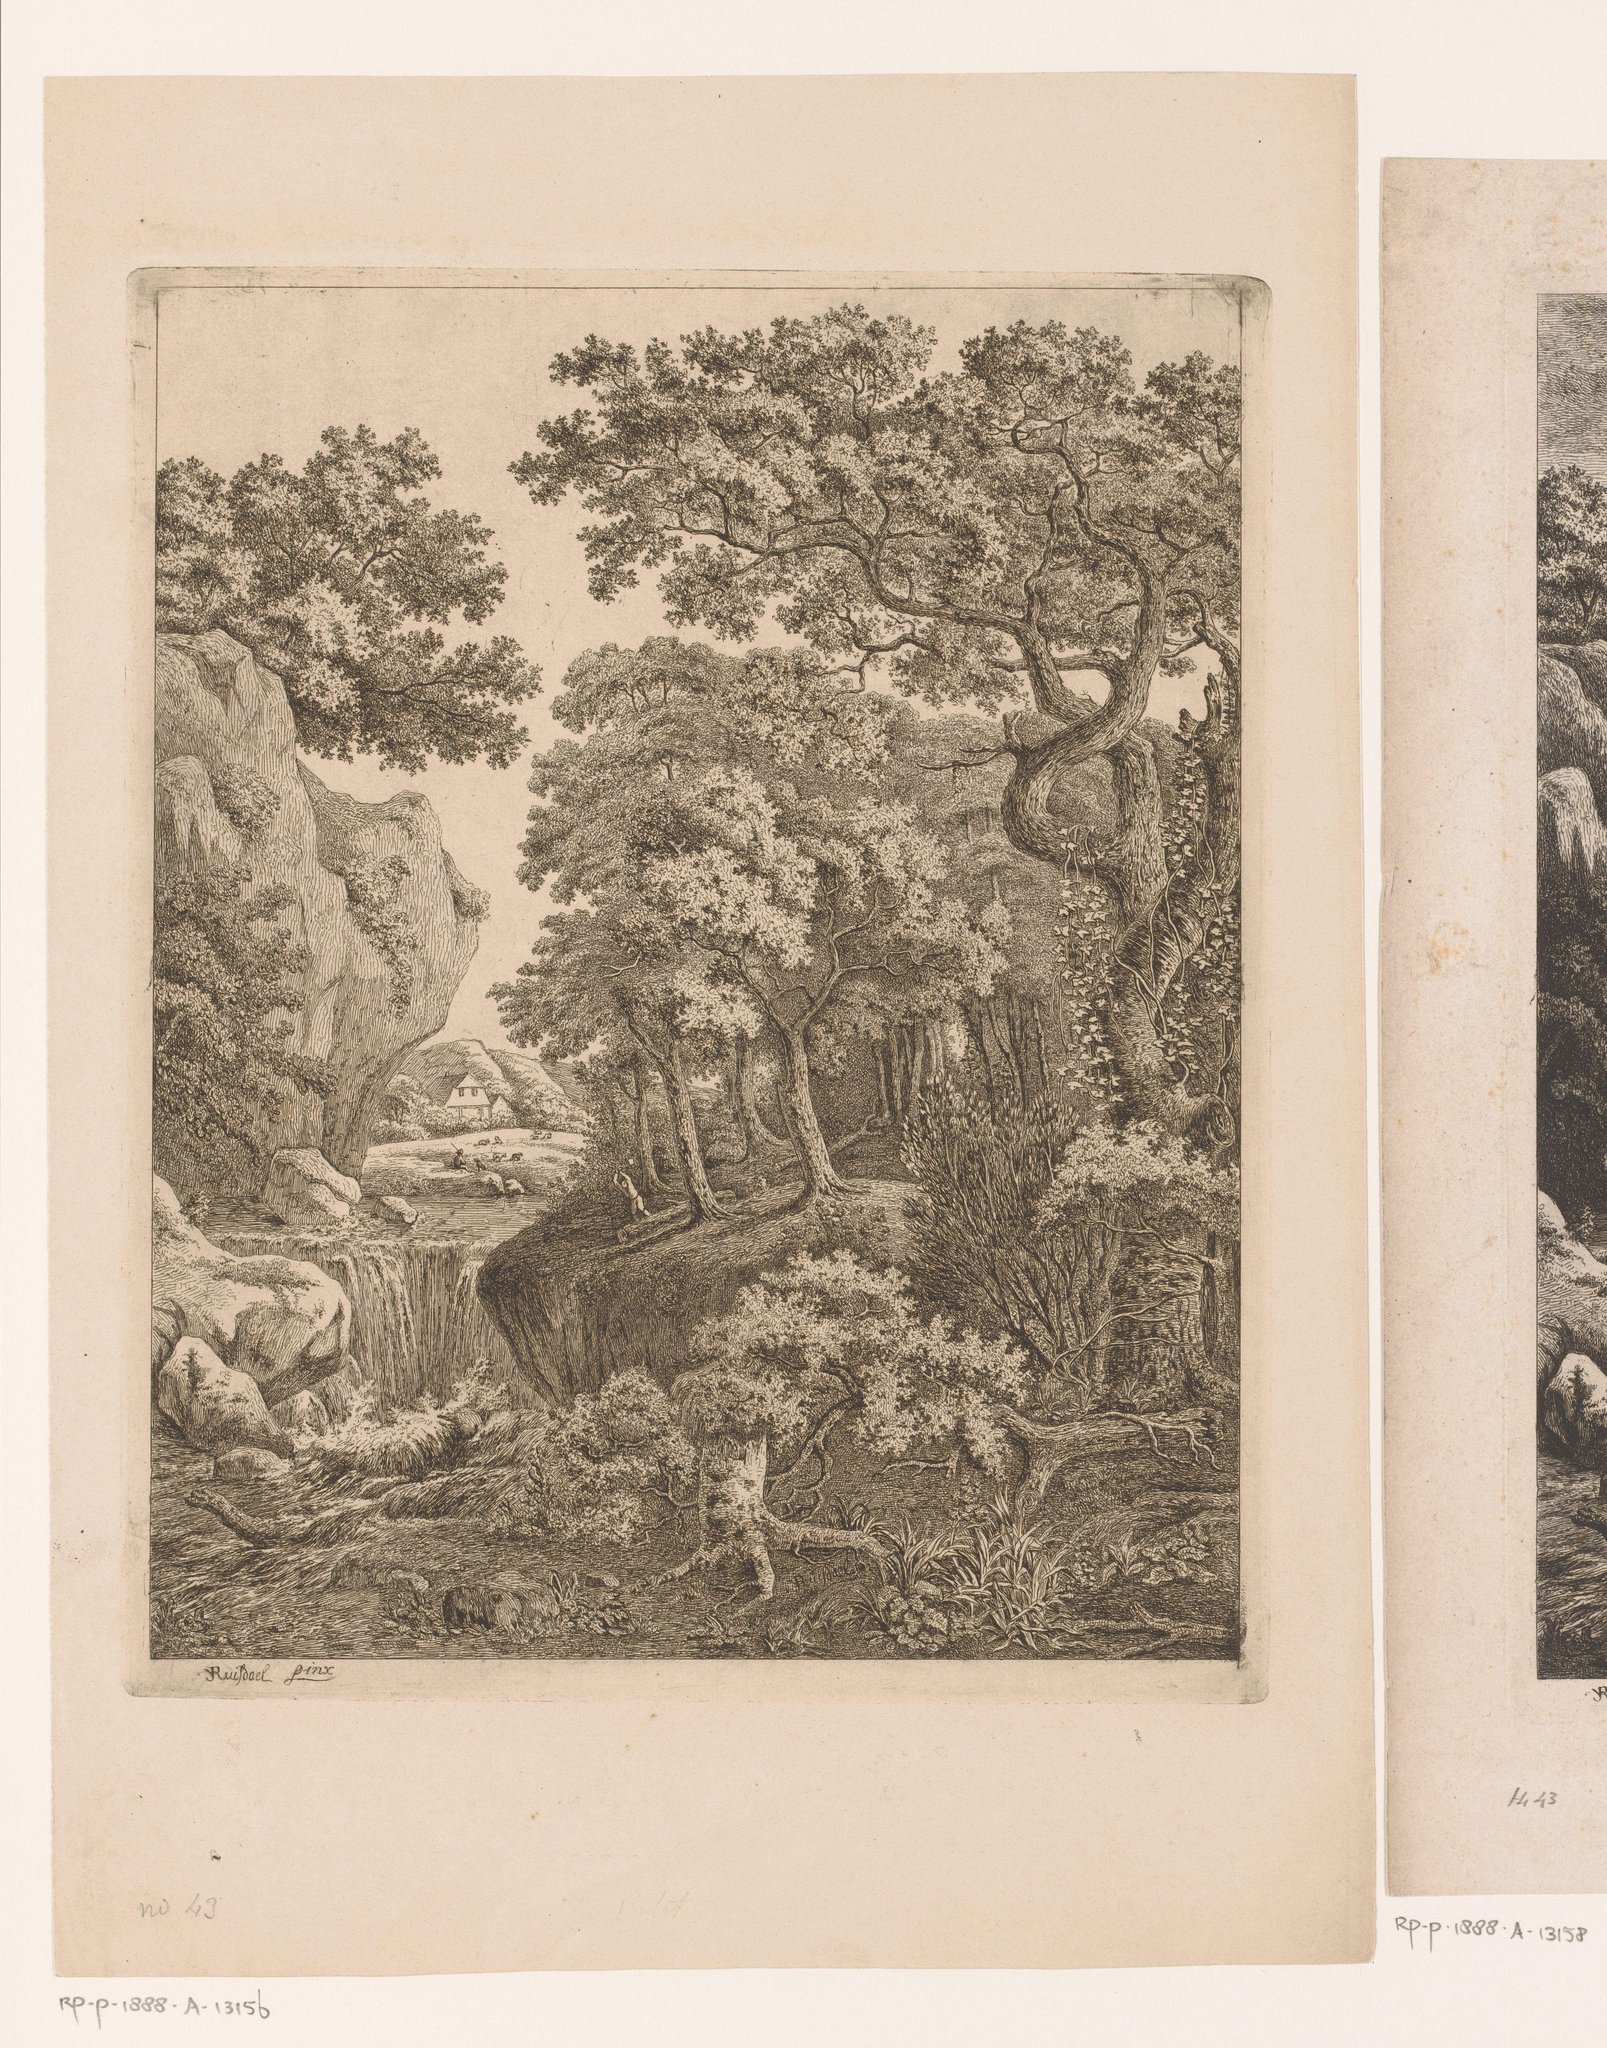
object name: print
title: Landschap met waterval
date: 1860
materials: paper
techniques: etching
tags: waterfall, forest, wood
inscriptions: collector's mark: Lugt 2228